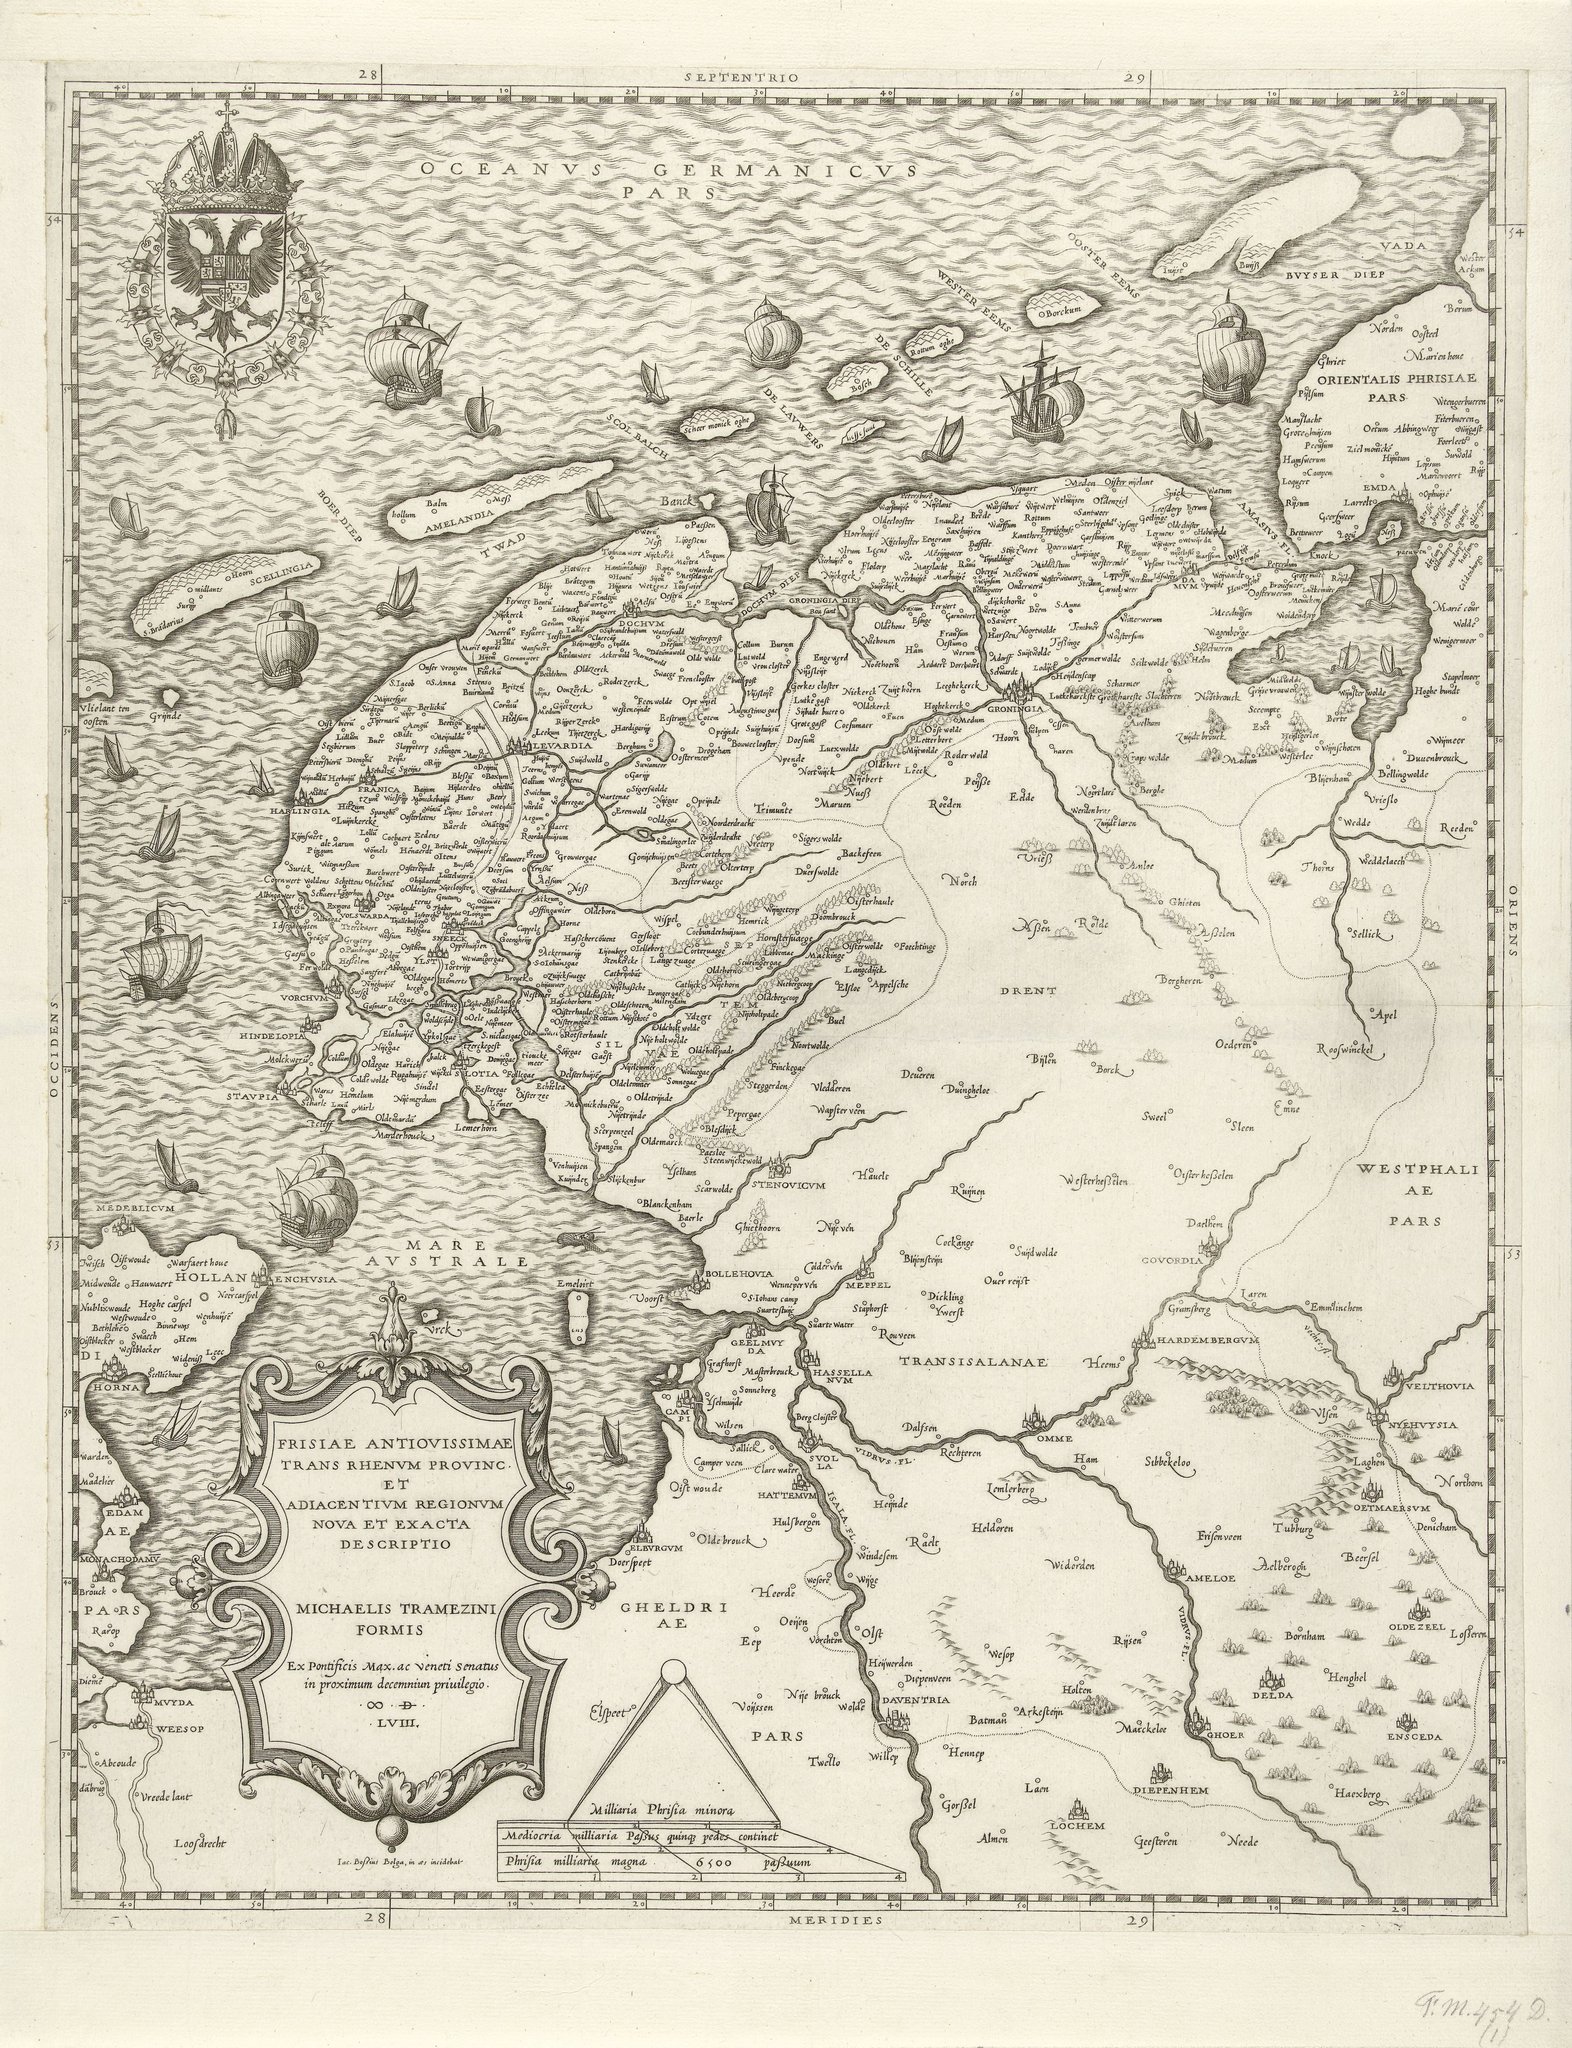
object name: map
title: Kaart van Friesland, Groningen, Drenthe en Overijssel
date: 1558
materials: paper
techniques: engraving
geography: italy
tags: maps of separate countries or regions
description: Kaart van Friesland, Groningen, Drenthe en Overijssel. Linksonder cartouche met titel, hierbij de passer met de schalen. Linksboven het keizerlijk wapen met Gulden Vlies. Alle opschriften in het Latijn.